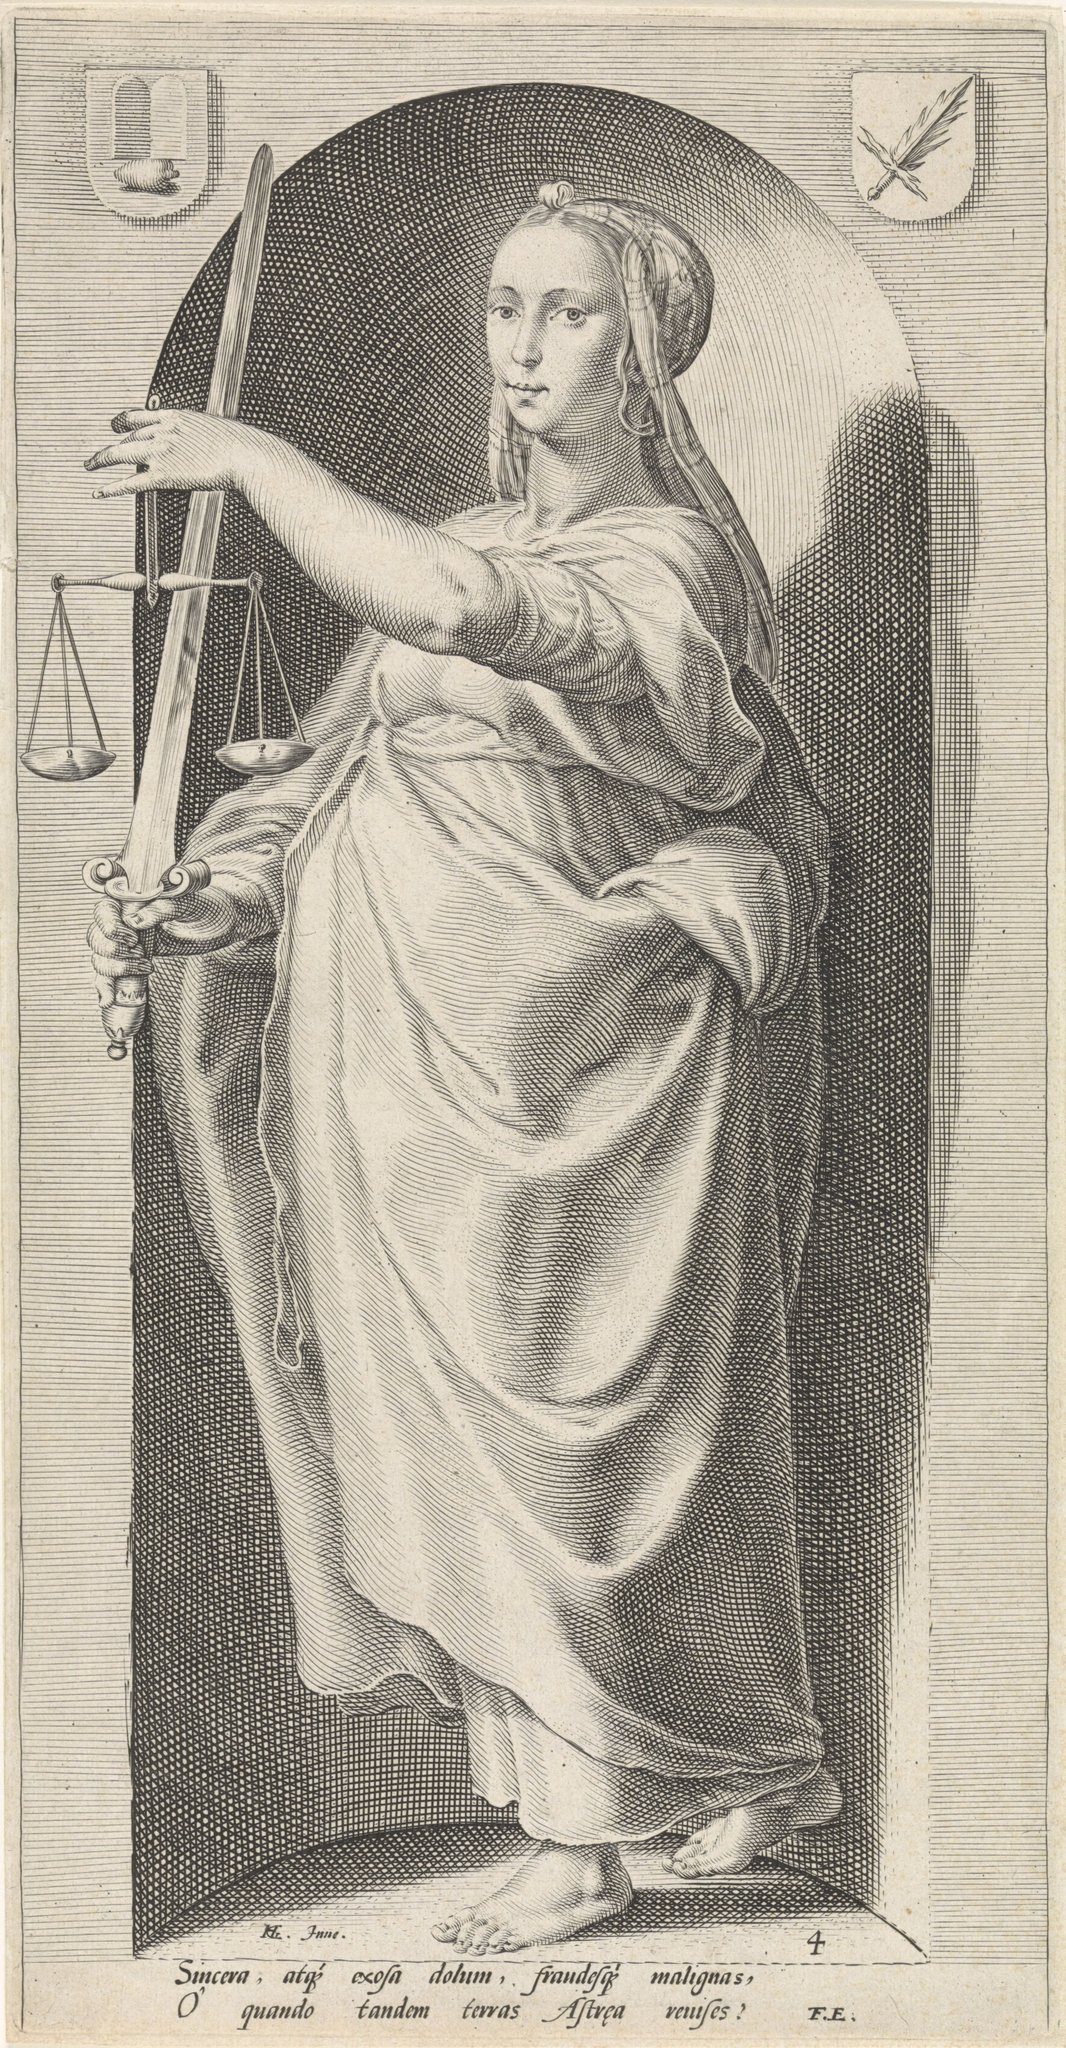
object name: print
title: Rechtvaardigheid (Justitia)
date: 1593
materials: paper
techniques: engraving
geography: haarlem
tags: justice, 'justitia'; 'giustitia divina' (ripa) ~ one of the four cardinal virtues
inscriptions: collector's mark: Lugt 2228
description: Personificatie van de rechtvaardigheid, met weegschaal en zwaard, staand in nis.